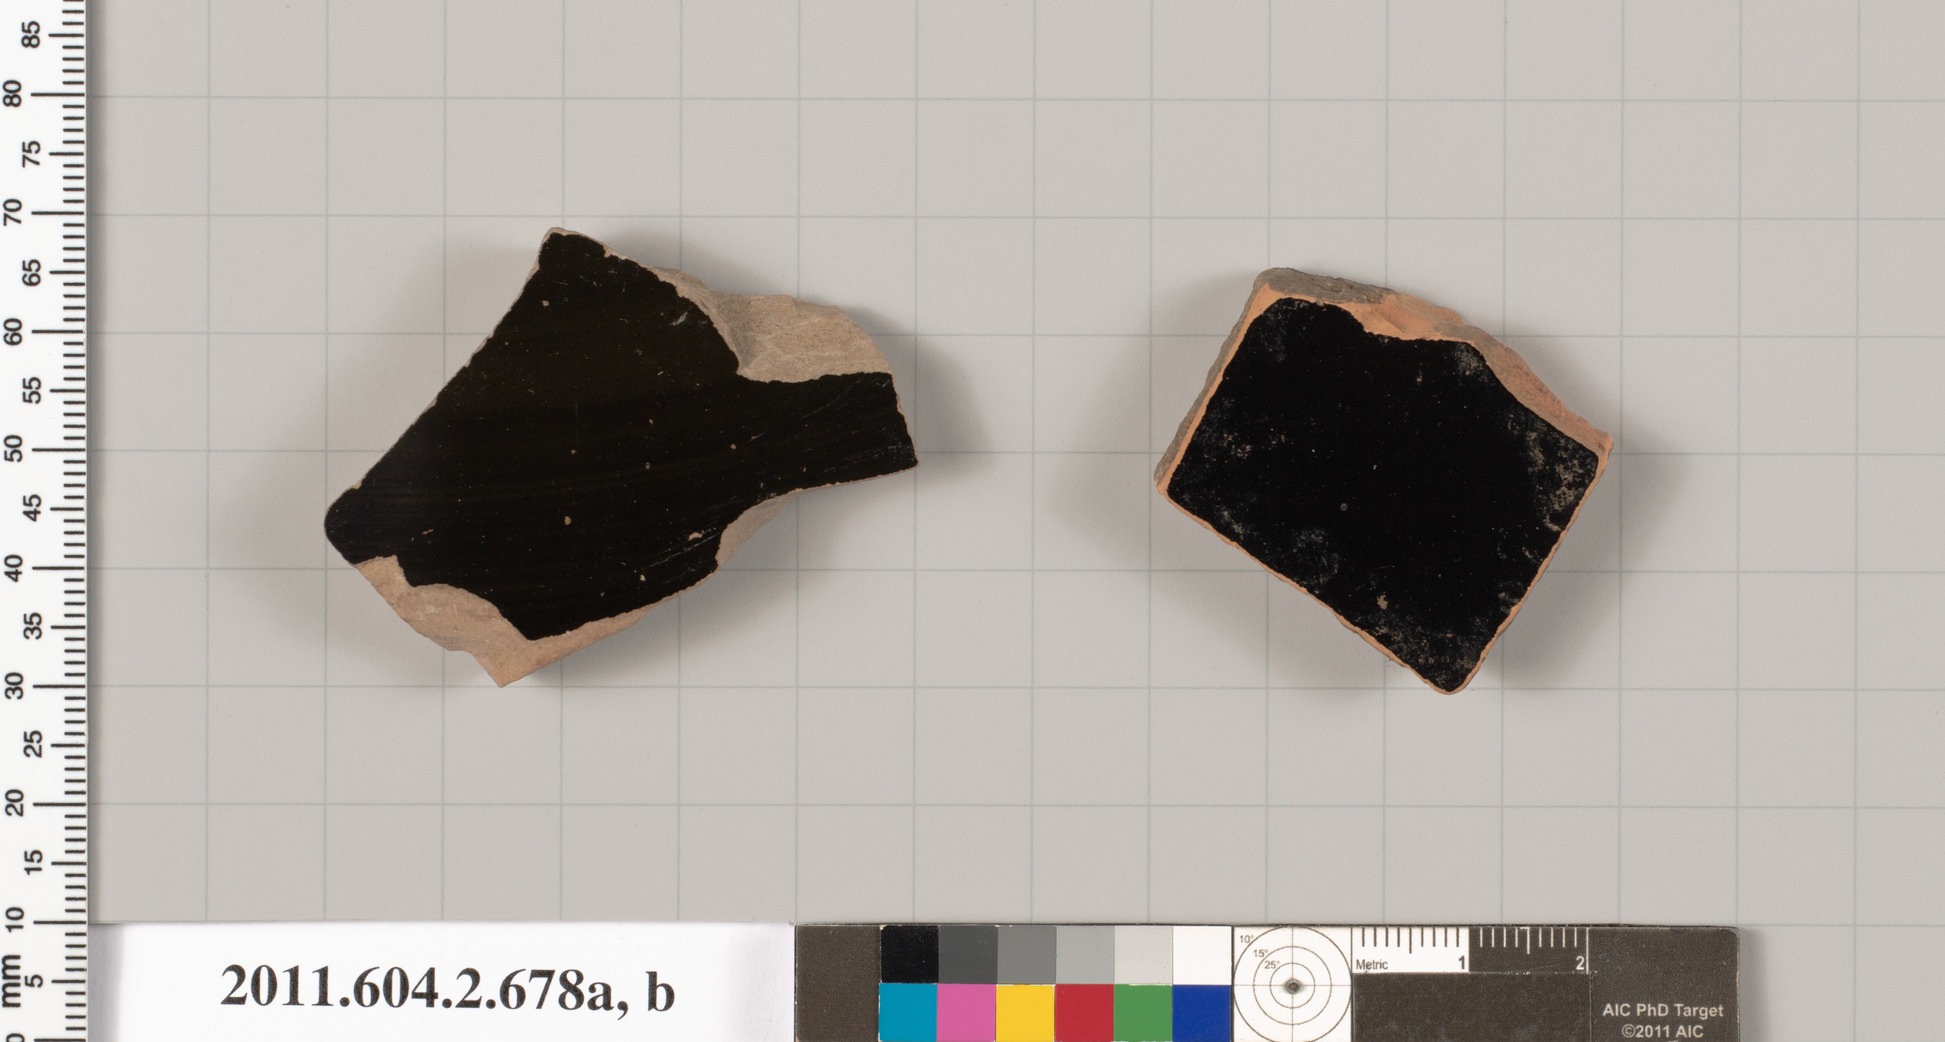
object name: column krater fragment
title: Terracotta fragments of column-kraters (bowls for mixing wine and water)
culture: greek, attic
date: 475-440 BCE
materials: terracotta